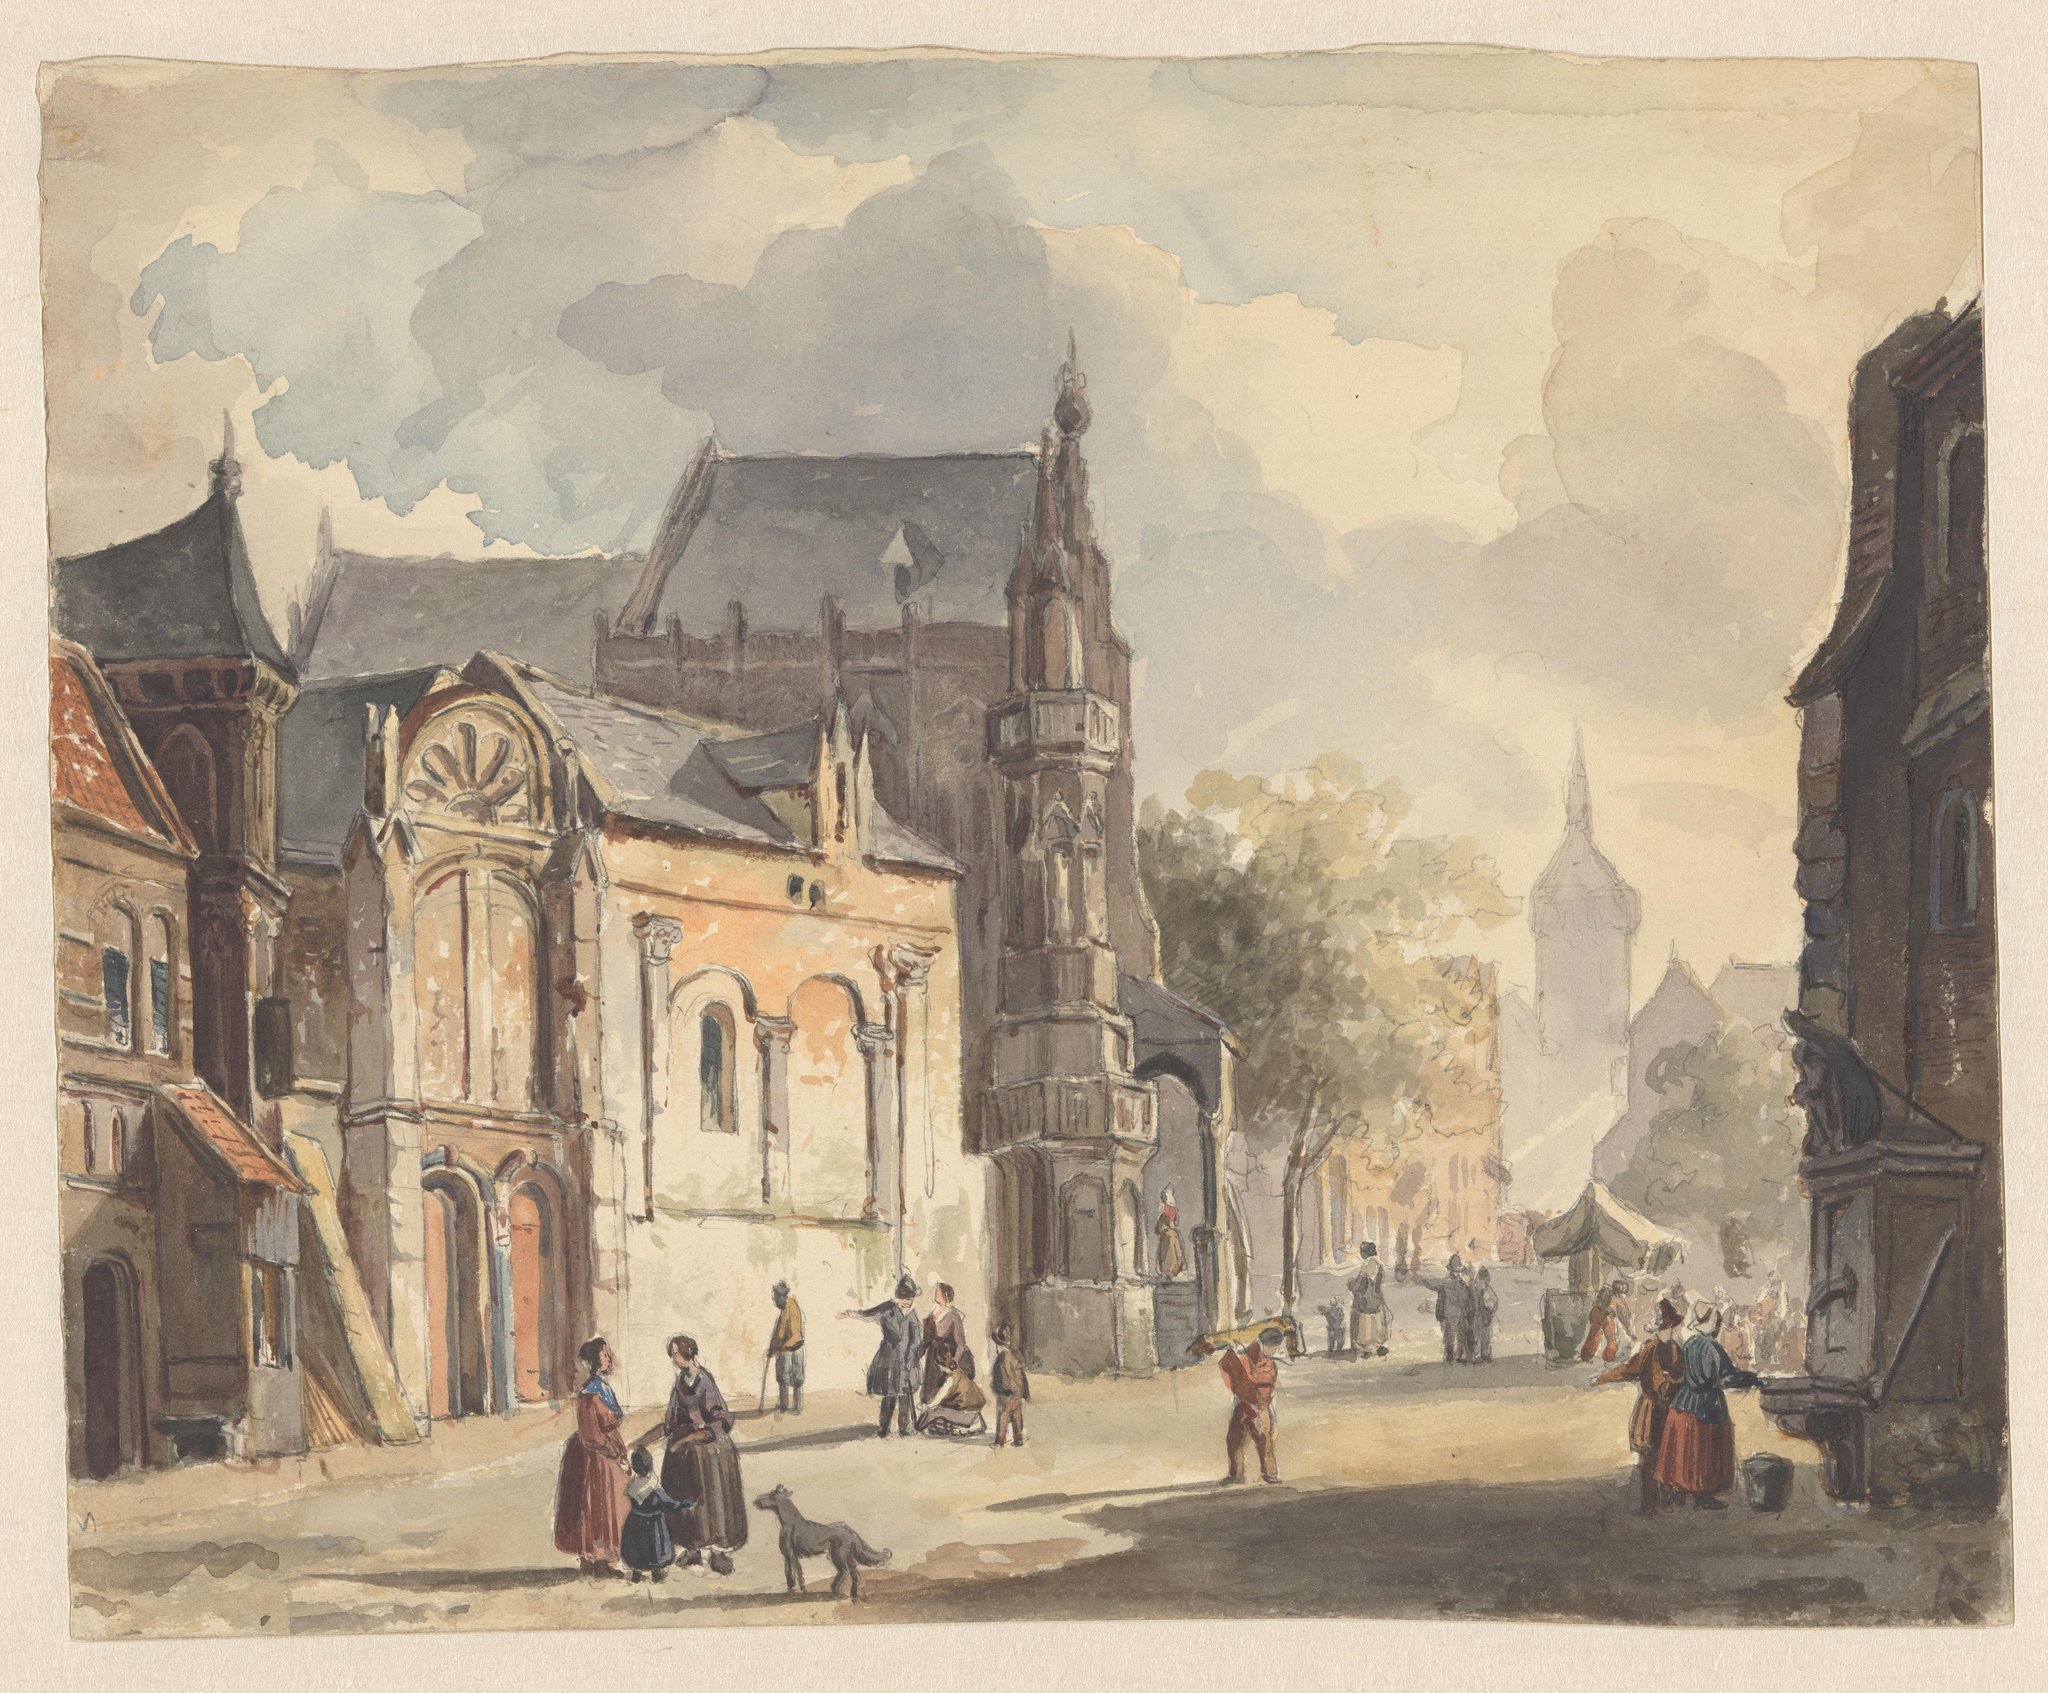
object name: drawing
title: Stadsgezicht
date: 1840-1860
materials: paper, pencil, watercolor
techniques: brush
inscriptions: number: ‘00:499’